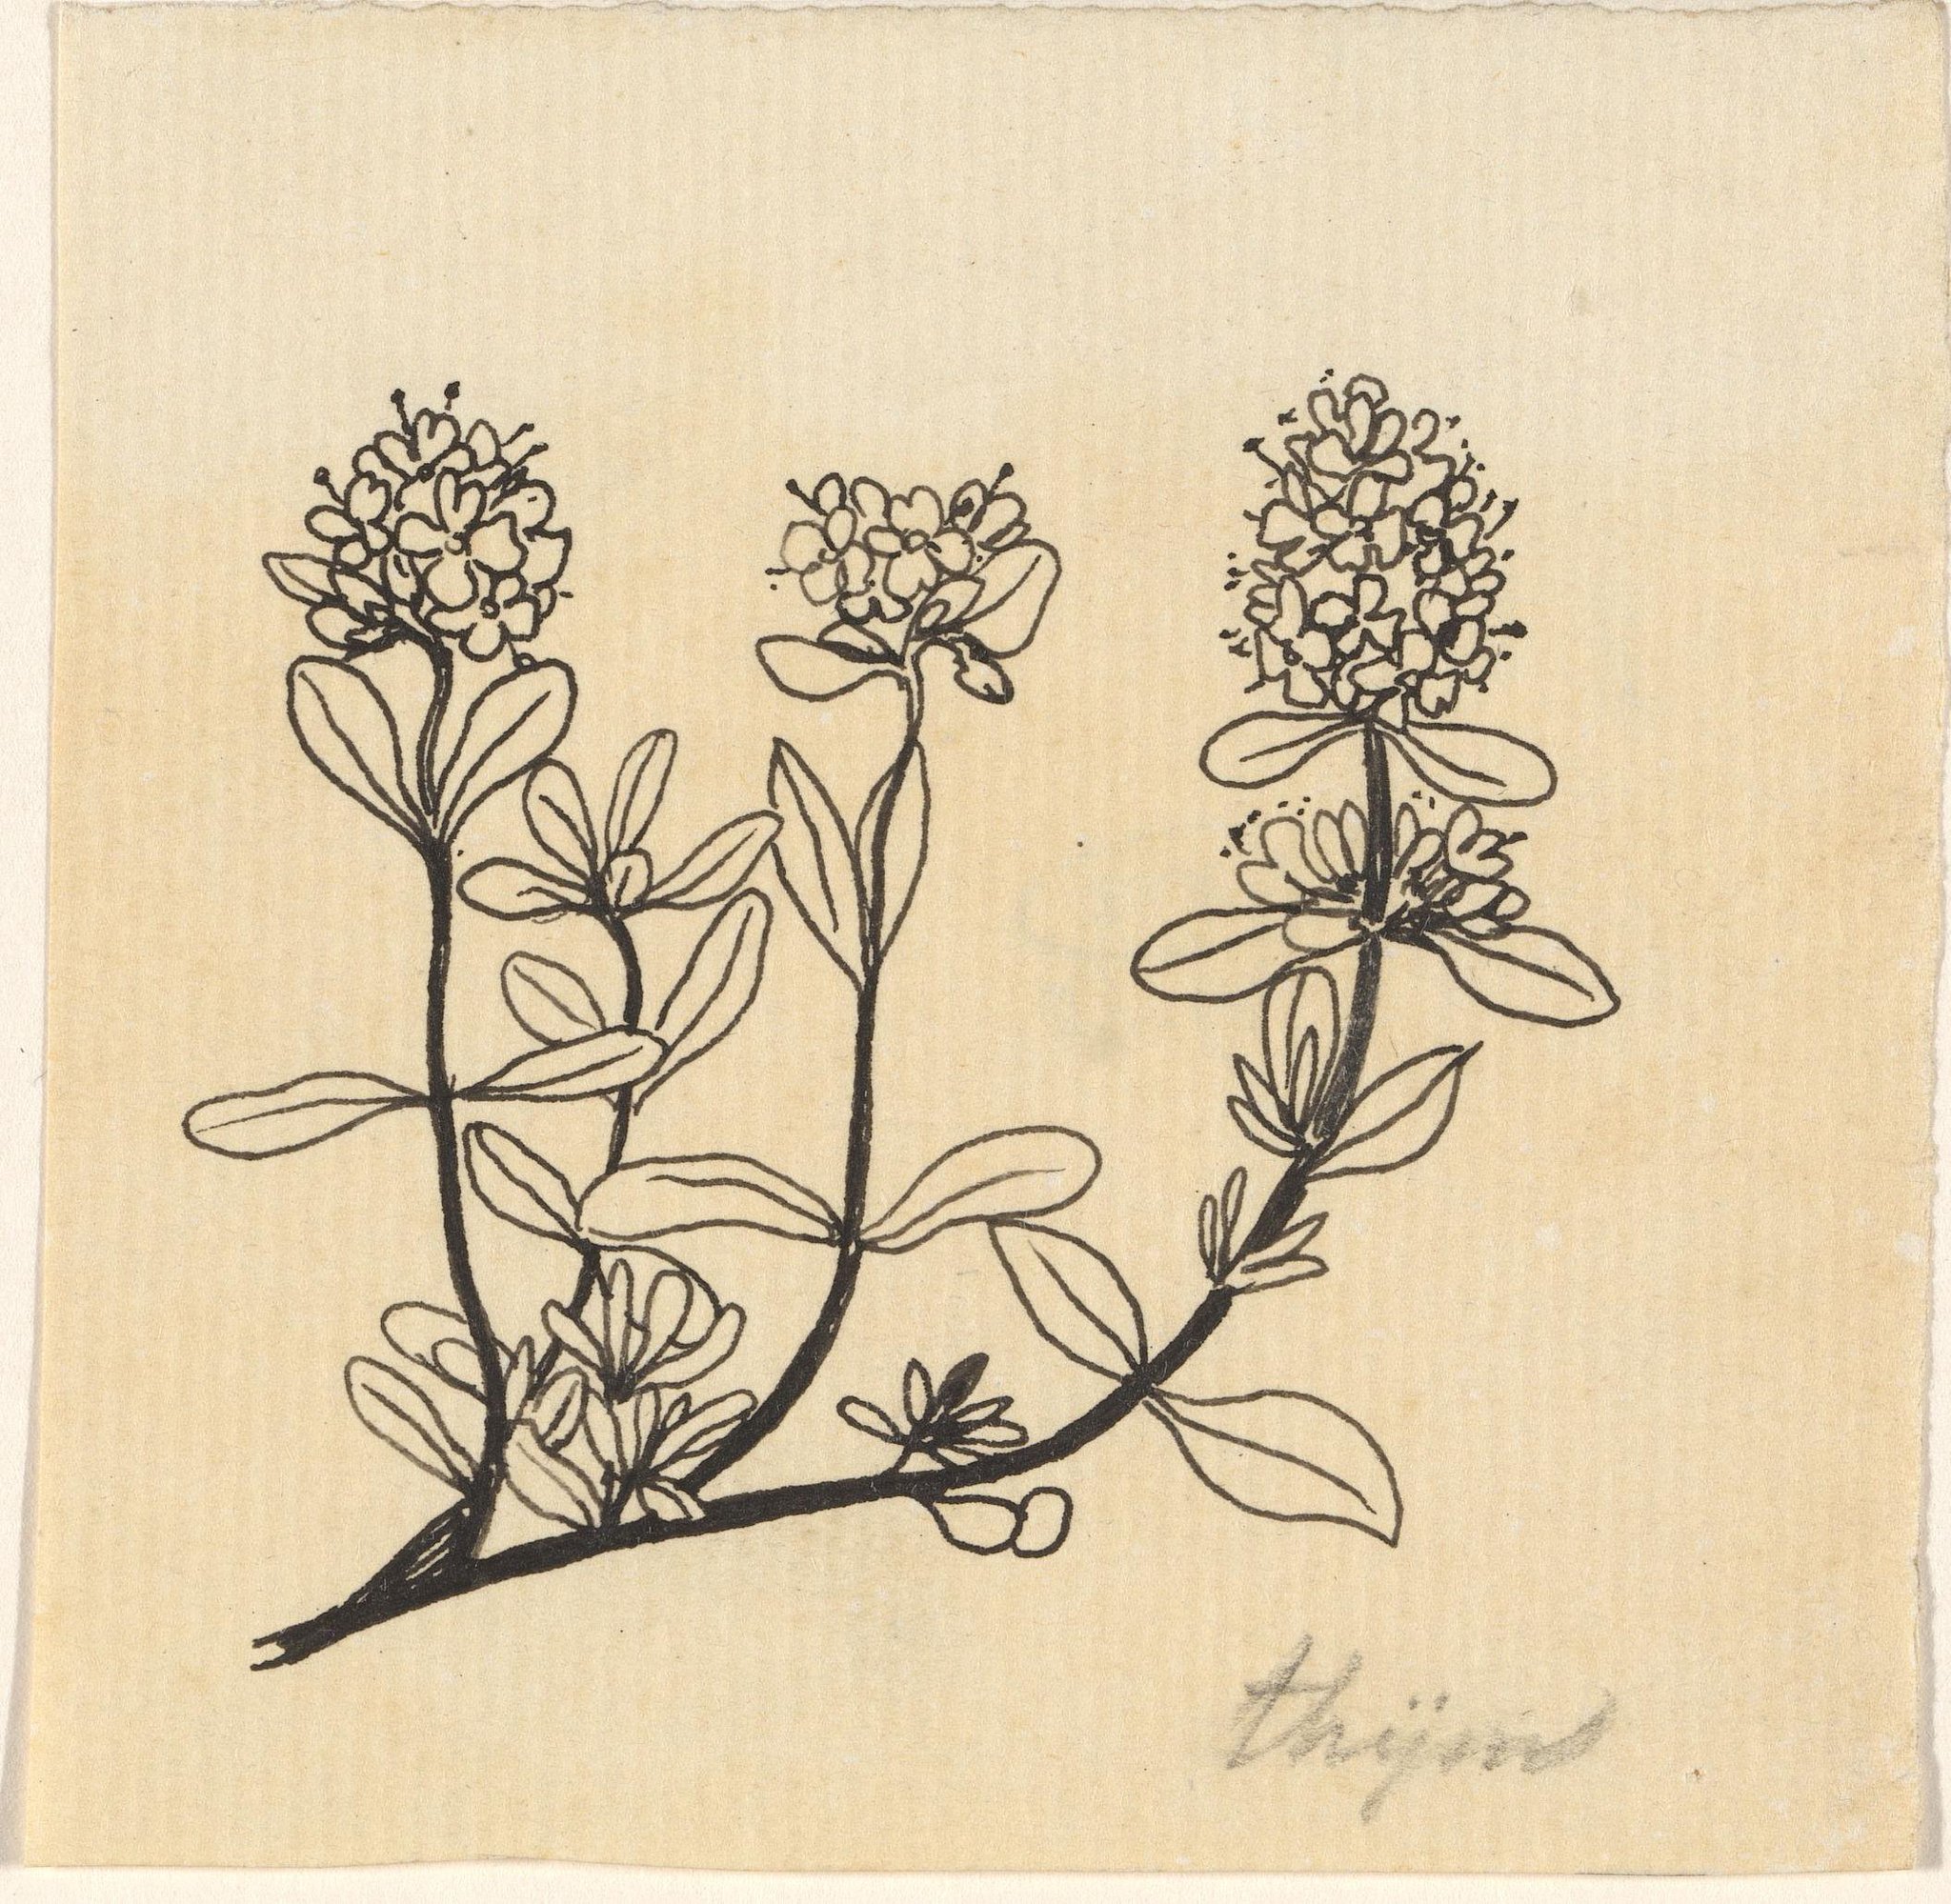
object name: drawing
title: Tijm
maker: willem wenckebach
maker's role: designer, draughtsman, painter, print maker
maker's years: 1860-1937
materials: ink, paper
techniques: pen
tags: 25g4(thyme)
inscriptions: annotation: ‘thijm’, collector's mark: Lugt 2228a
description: Ontwerp voor: Knappert, Emilie C. Kijkjes in de plantenwereld. Loman & Funke: Amsterdam, 1893.